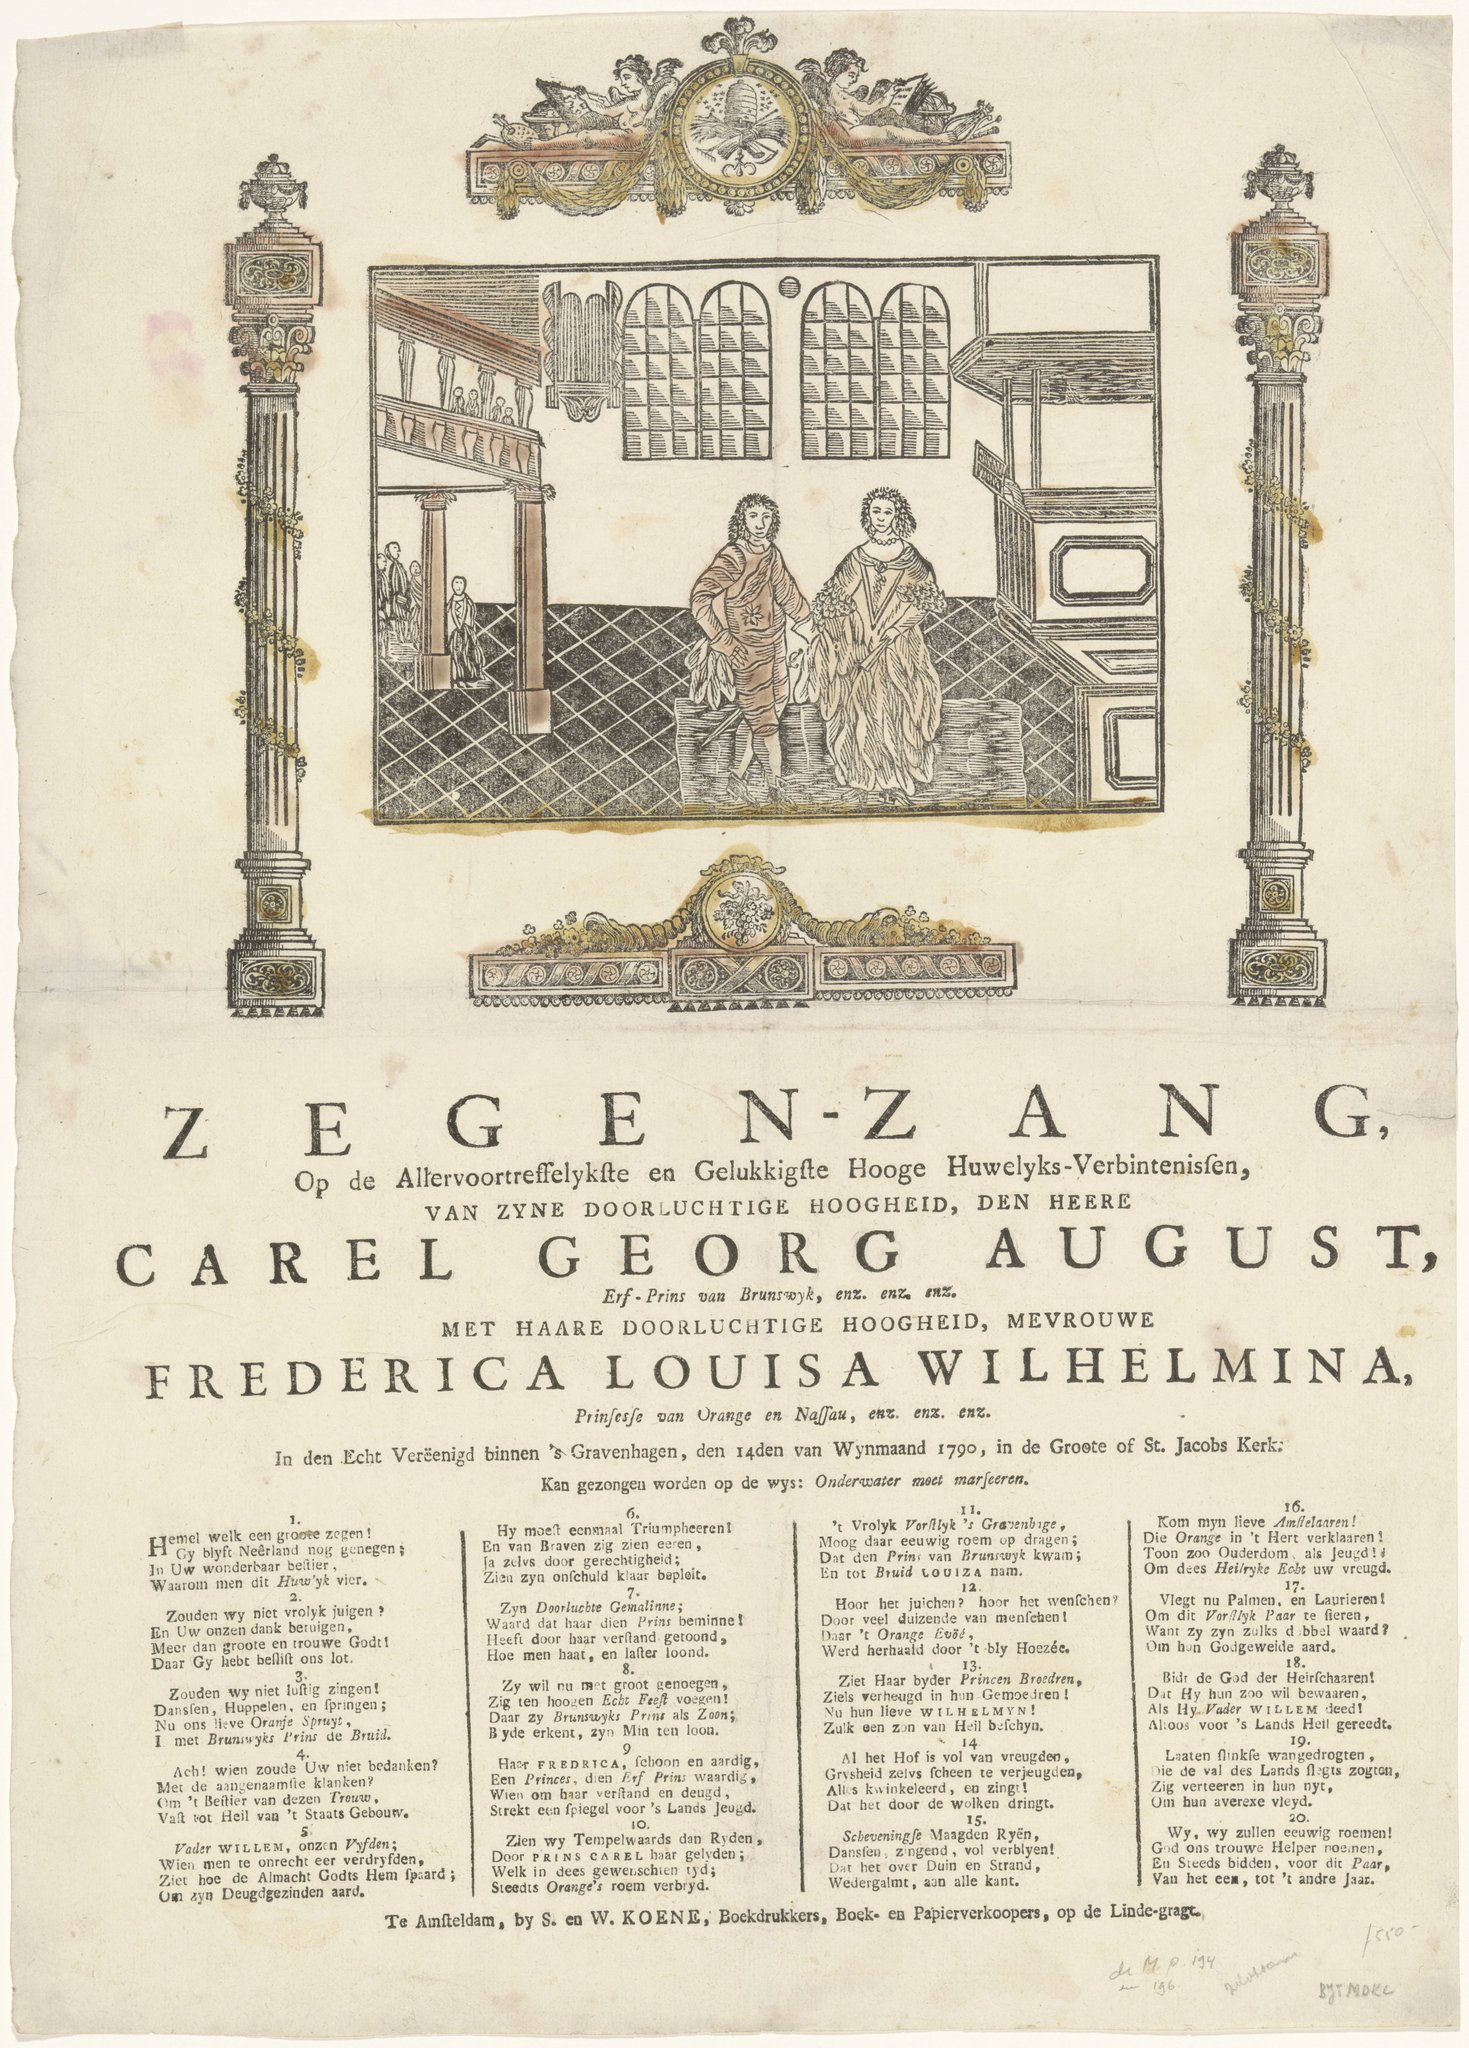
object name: print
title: Zegen-zang, / Op de allervoortreffelykste en gelukkigste hooge huwelyks-verbintenissen (...)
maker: Anonymous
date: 1781-1800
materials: paper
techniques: colour, letterpress printing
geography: netherlands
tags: karel van brunswijk-wolfenbüttel, berlin, the hague, wilhelmina frederica louisa (koningin der nederlanden), bride and groom in wedding-dress, (civil) marriage ceremonies, nobility and patriciate; chivalry, knighthood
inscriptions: collector's mark: Lugt 2228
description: Huwelijk van Carel Georg August, erfprins van Brunswijk, en Frederica Louisa Wilhelmina, prinses van Oranje Nassau, waaromheen twee erezuilen en twee vignetten. Onder de afbeelding een vers in vier kolommen.